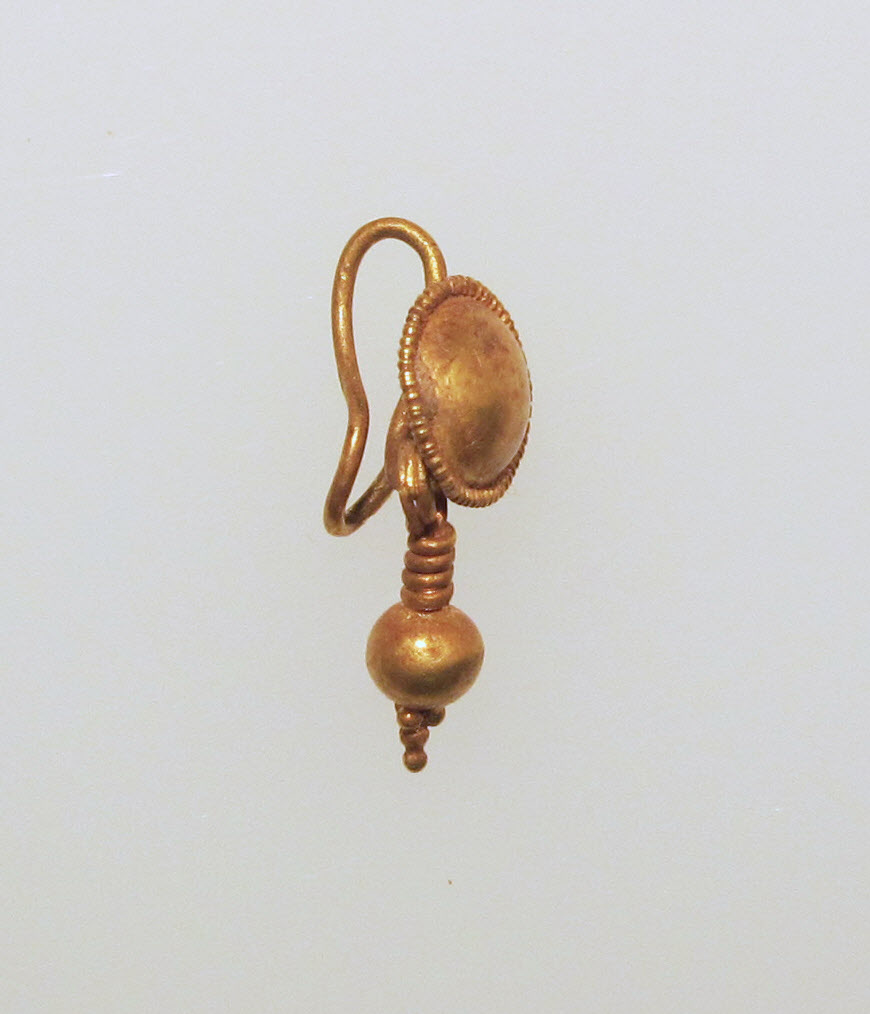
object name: earring hook type with pendant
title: Earring-hook type with ball pendant and disc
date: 7000 BCE-330 CE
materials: gold